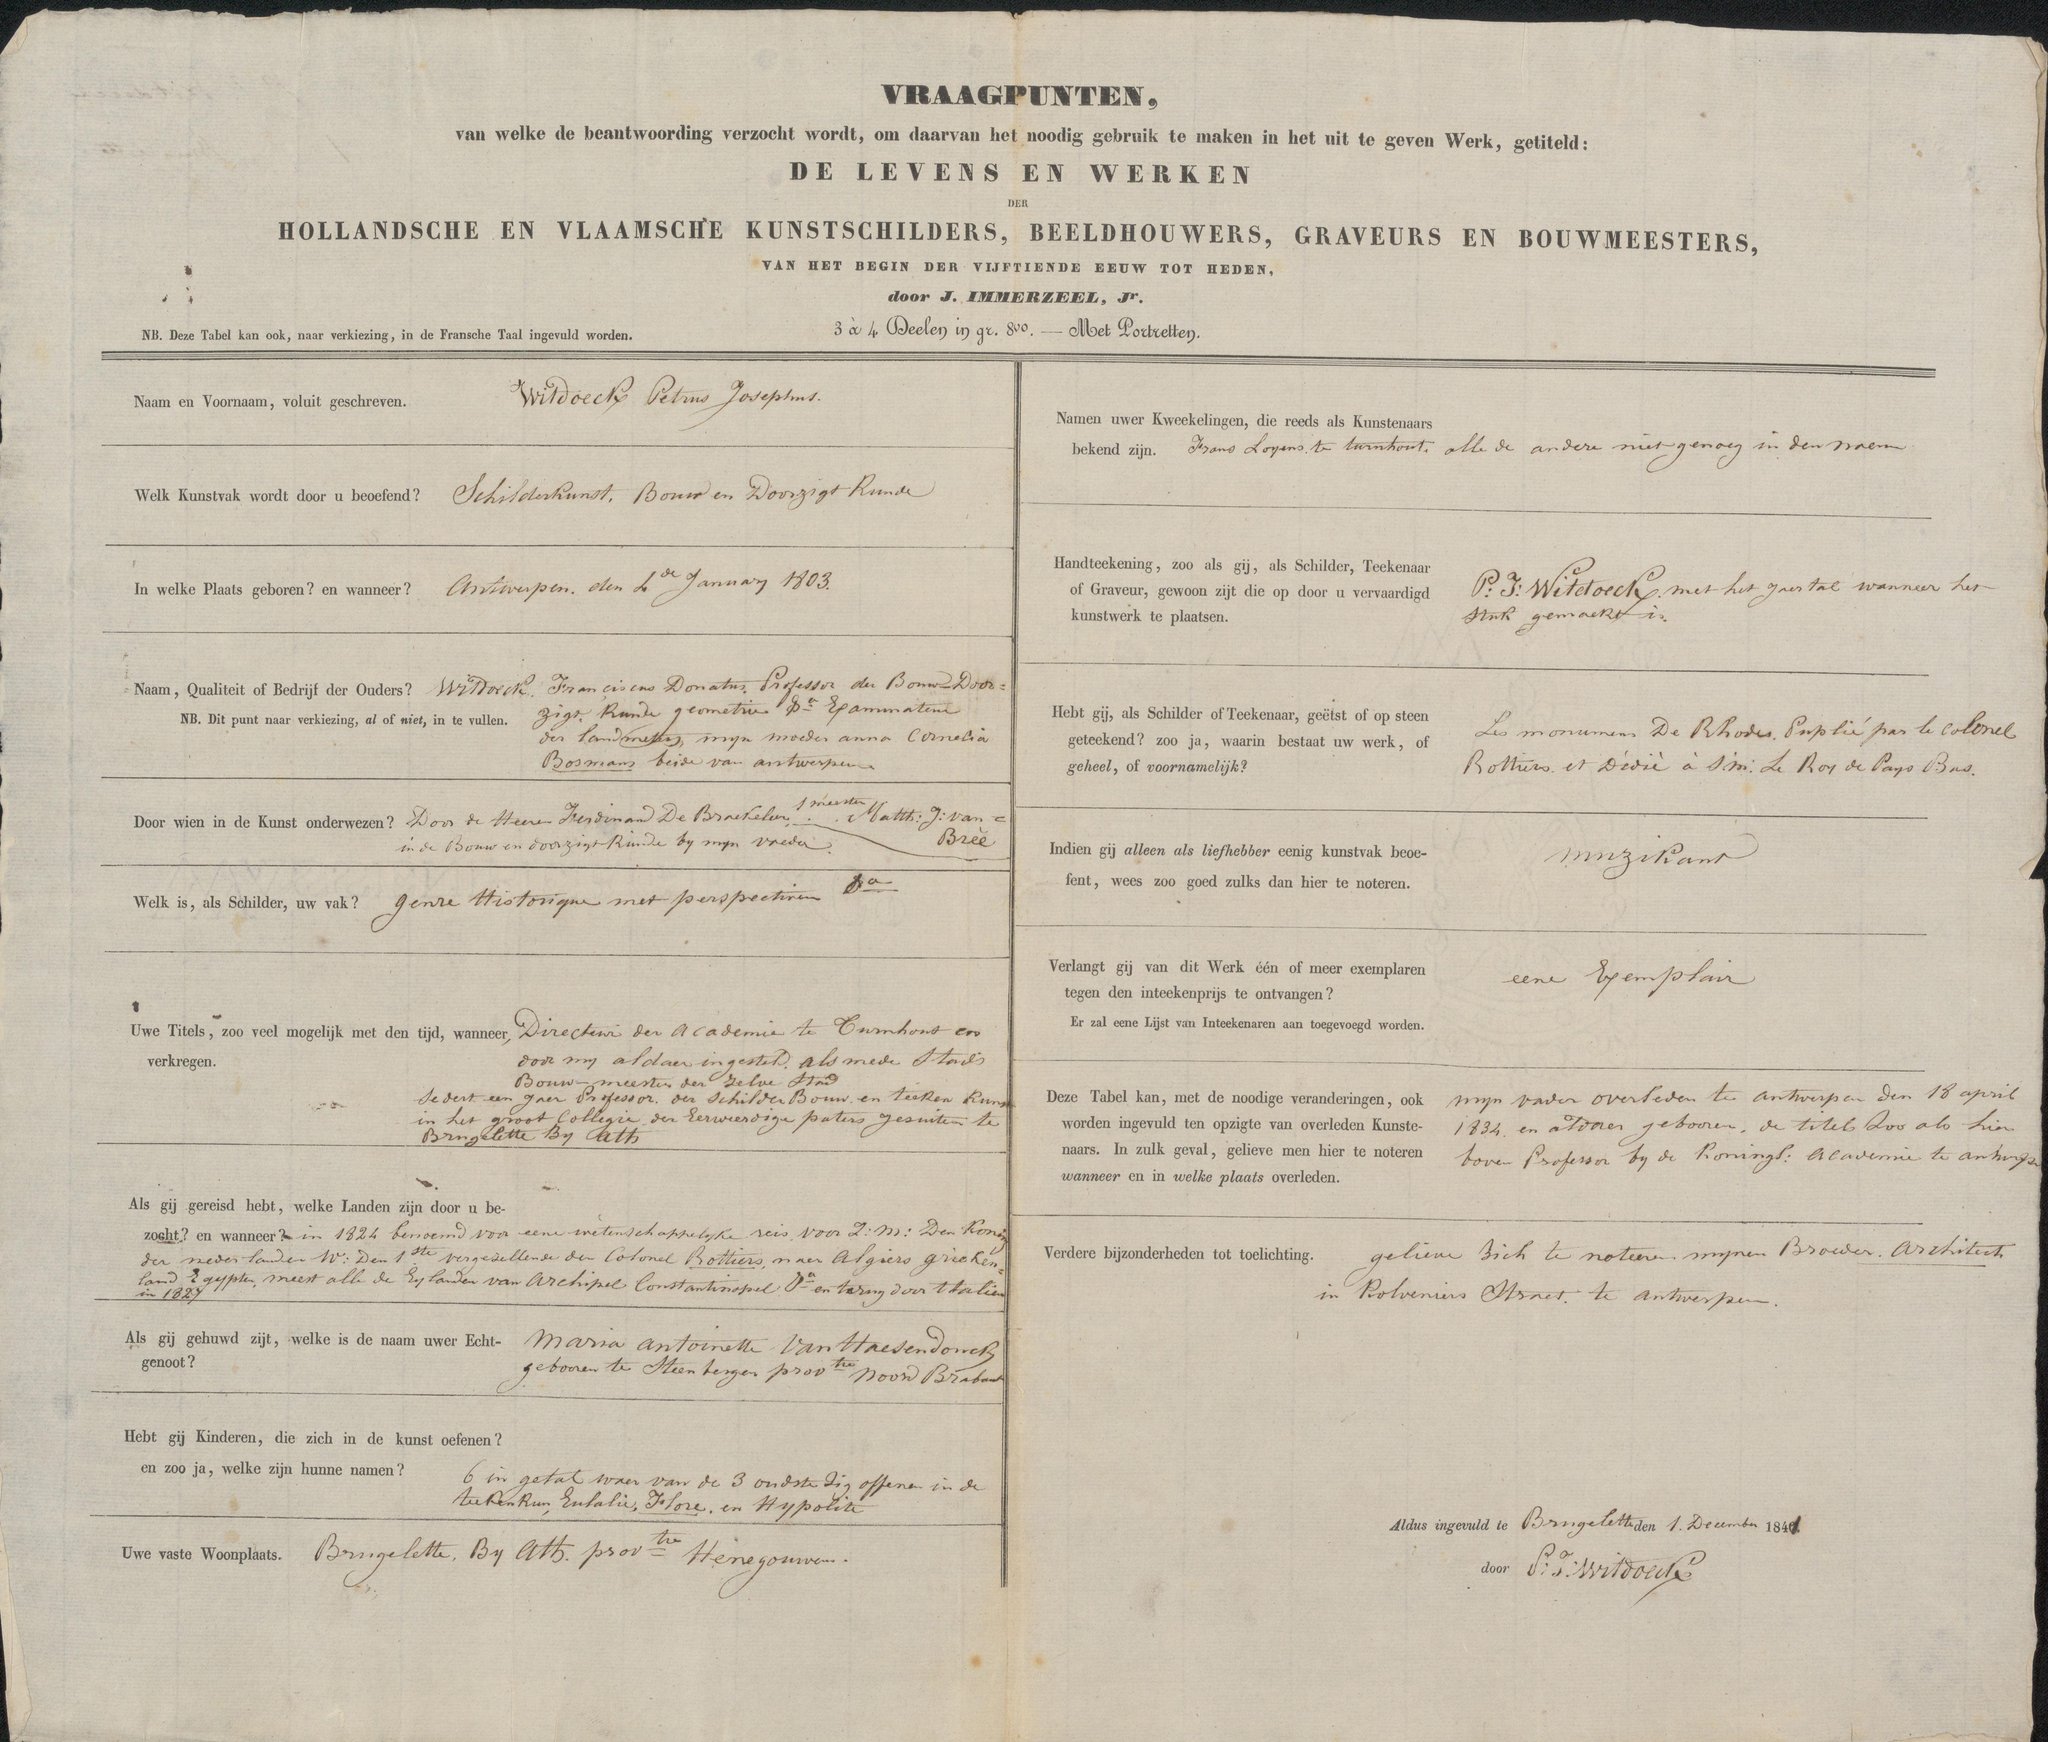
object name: manuscript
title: Enquêteformulier ingevuld door Pierre Joseph Witdoeck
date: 1841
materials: ink, paper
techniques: pen, printing, writing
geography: brugelette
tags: antwerp, pierre joseph witdoeck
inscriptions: watermark, inscription: ‘Vraagpunten,/ van welke de beantwoording verzocht wordt, om daarvan het noodig gebruik te maken in het uit te geven Werk, getiteld: De levens en werken/ der Hollandsche en Vlaamsche kunstschilders, beeldhouwers,/ graveurs en bouwmeesters, van het begin der vijftiende eeuw tot heden/ door J. Immerzeel, Jr.’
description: Opgenomen in: Immerzeel, J. Jr., De levens en werken der Hollandsche en Vlaamsche kunstschilders, beeldhouwers, graveurs en bouwmeesters, van het begin der vijftiende eeuw tot heden, Amsterdam: J.C. van Kesteren, 1842-1843.